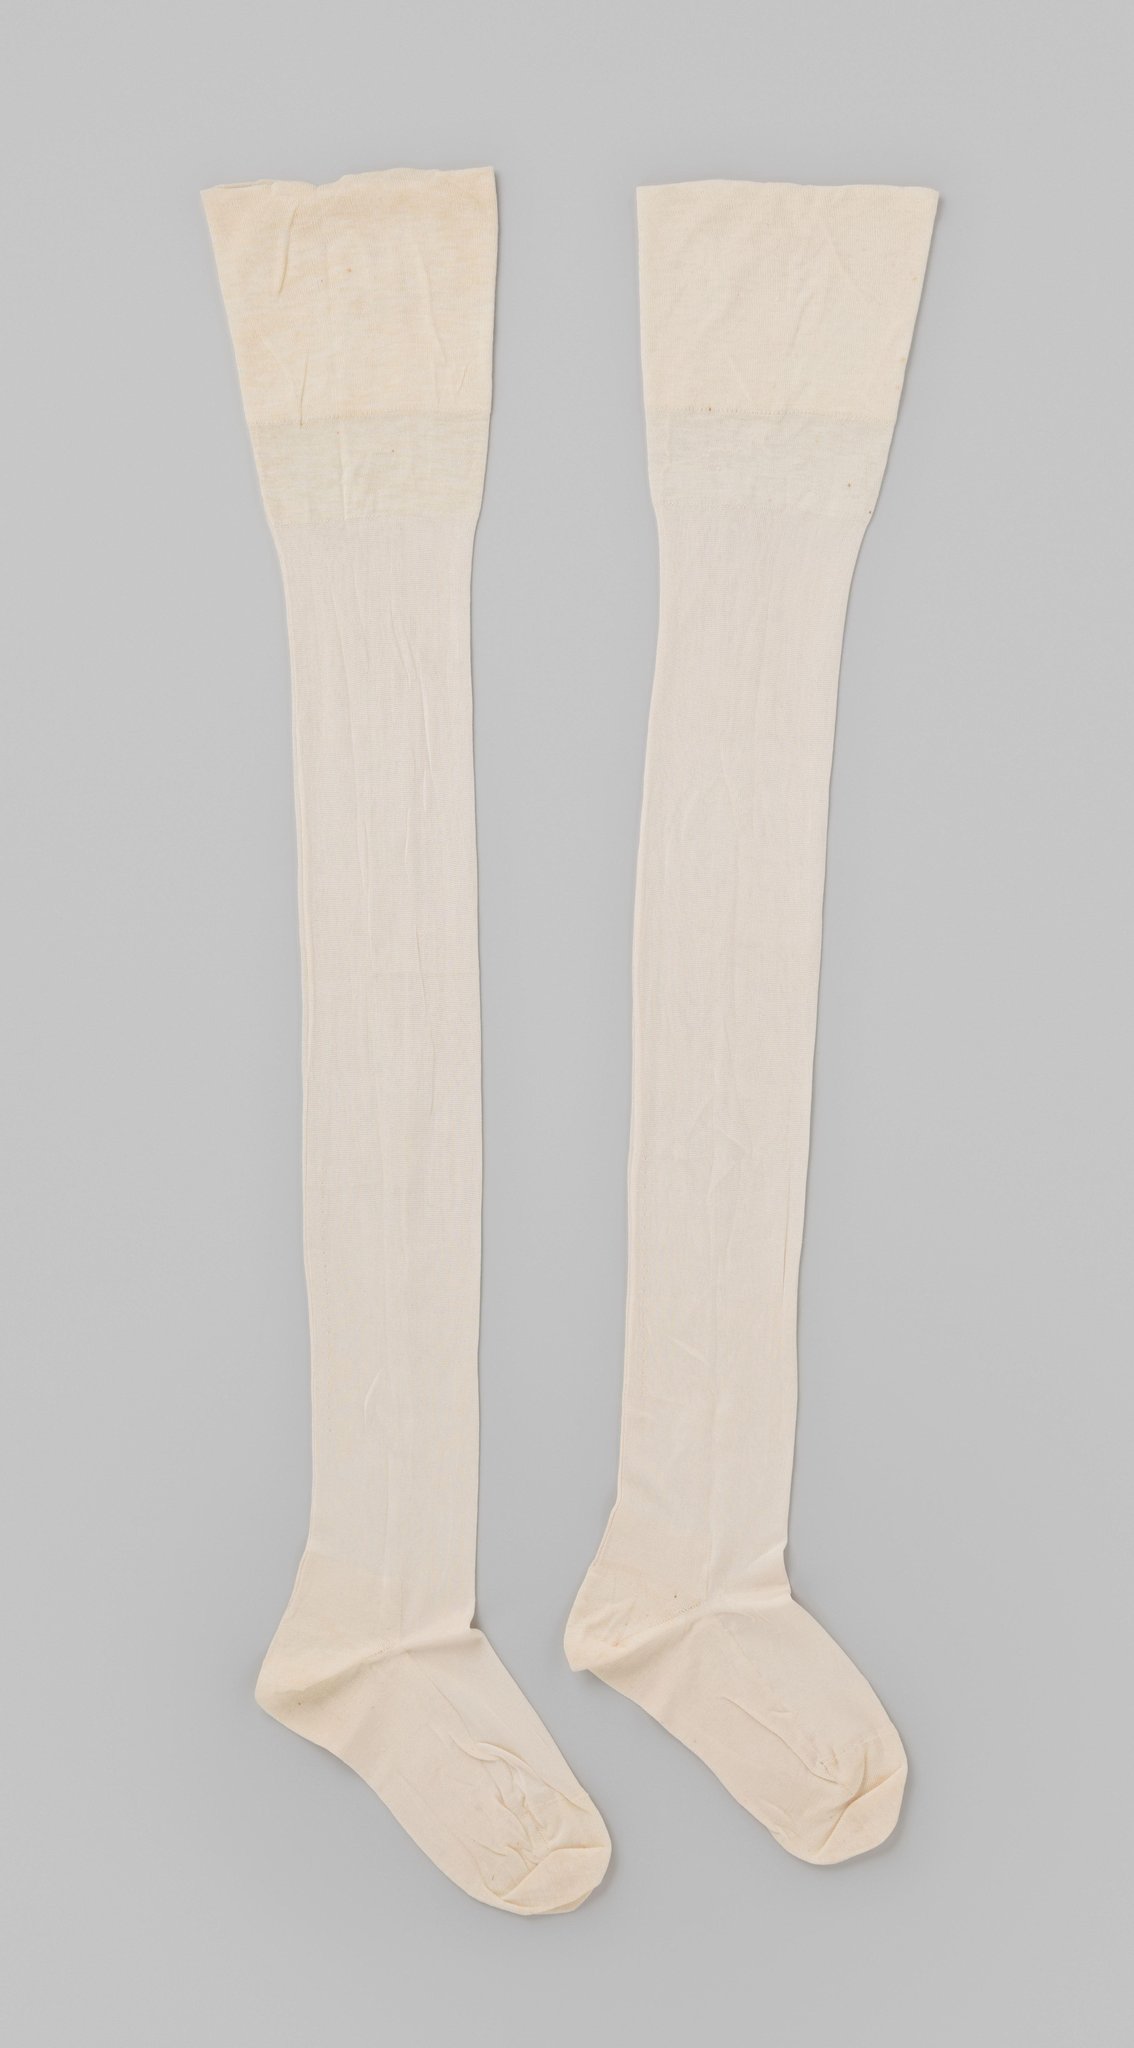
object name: stocking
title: Kous gebreid van witte zijde met een brede katoenen boord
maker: Anonymous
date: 1910-1920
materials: cotton, silk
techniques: knitting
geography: lille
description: Kous, van een paar, van witte zijde. Model: met naad. Boord van katoen. Vierkante hiel.